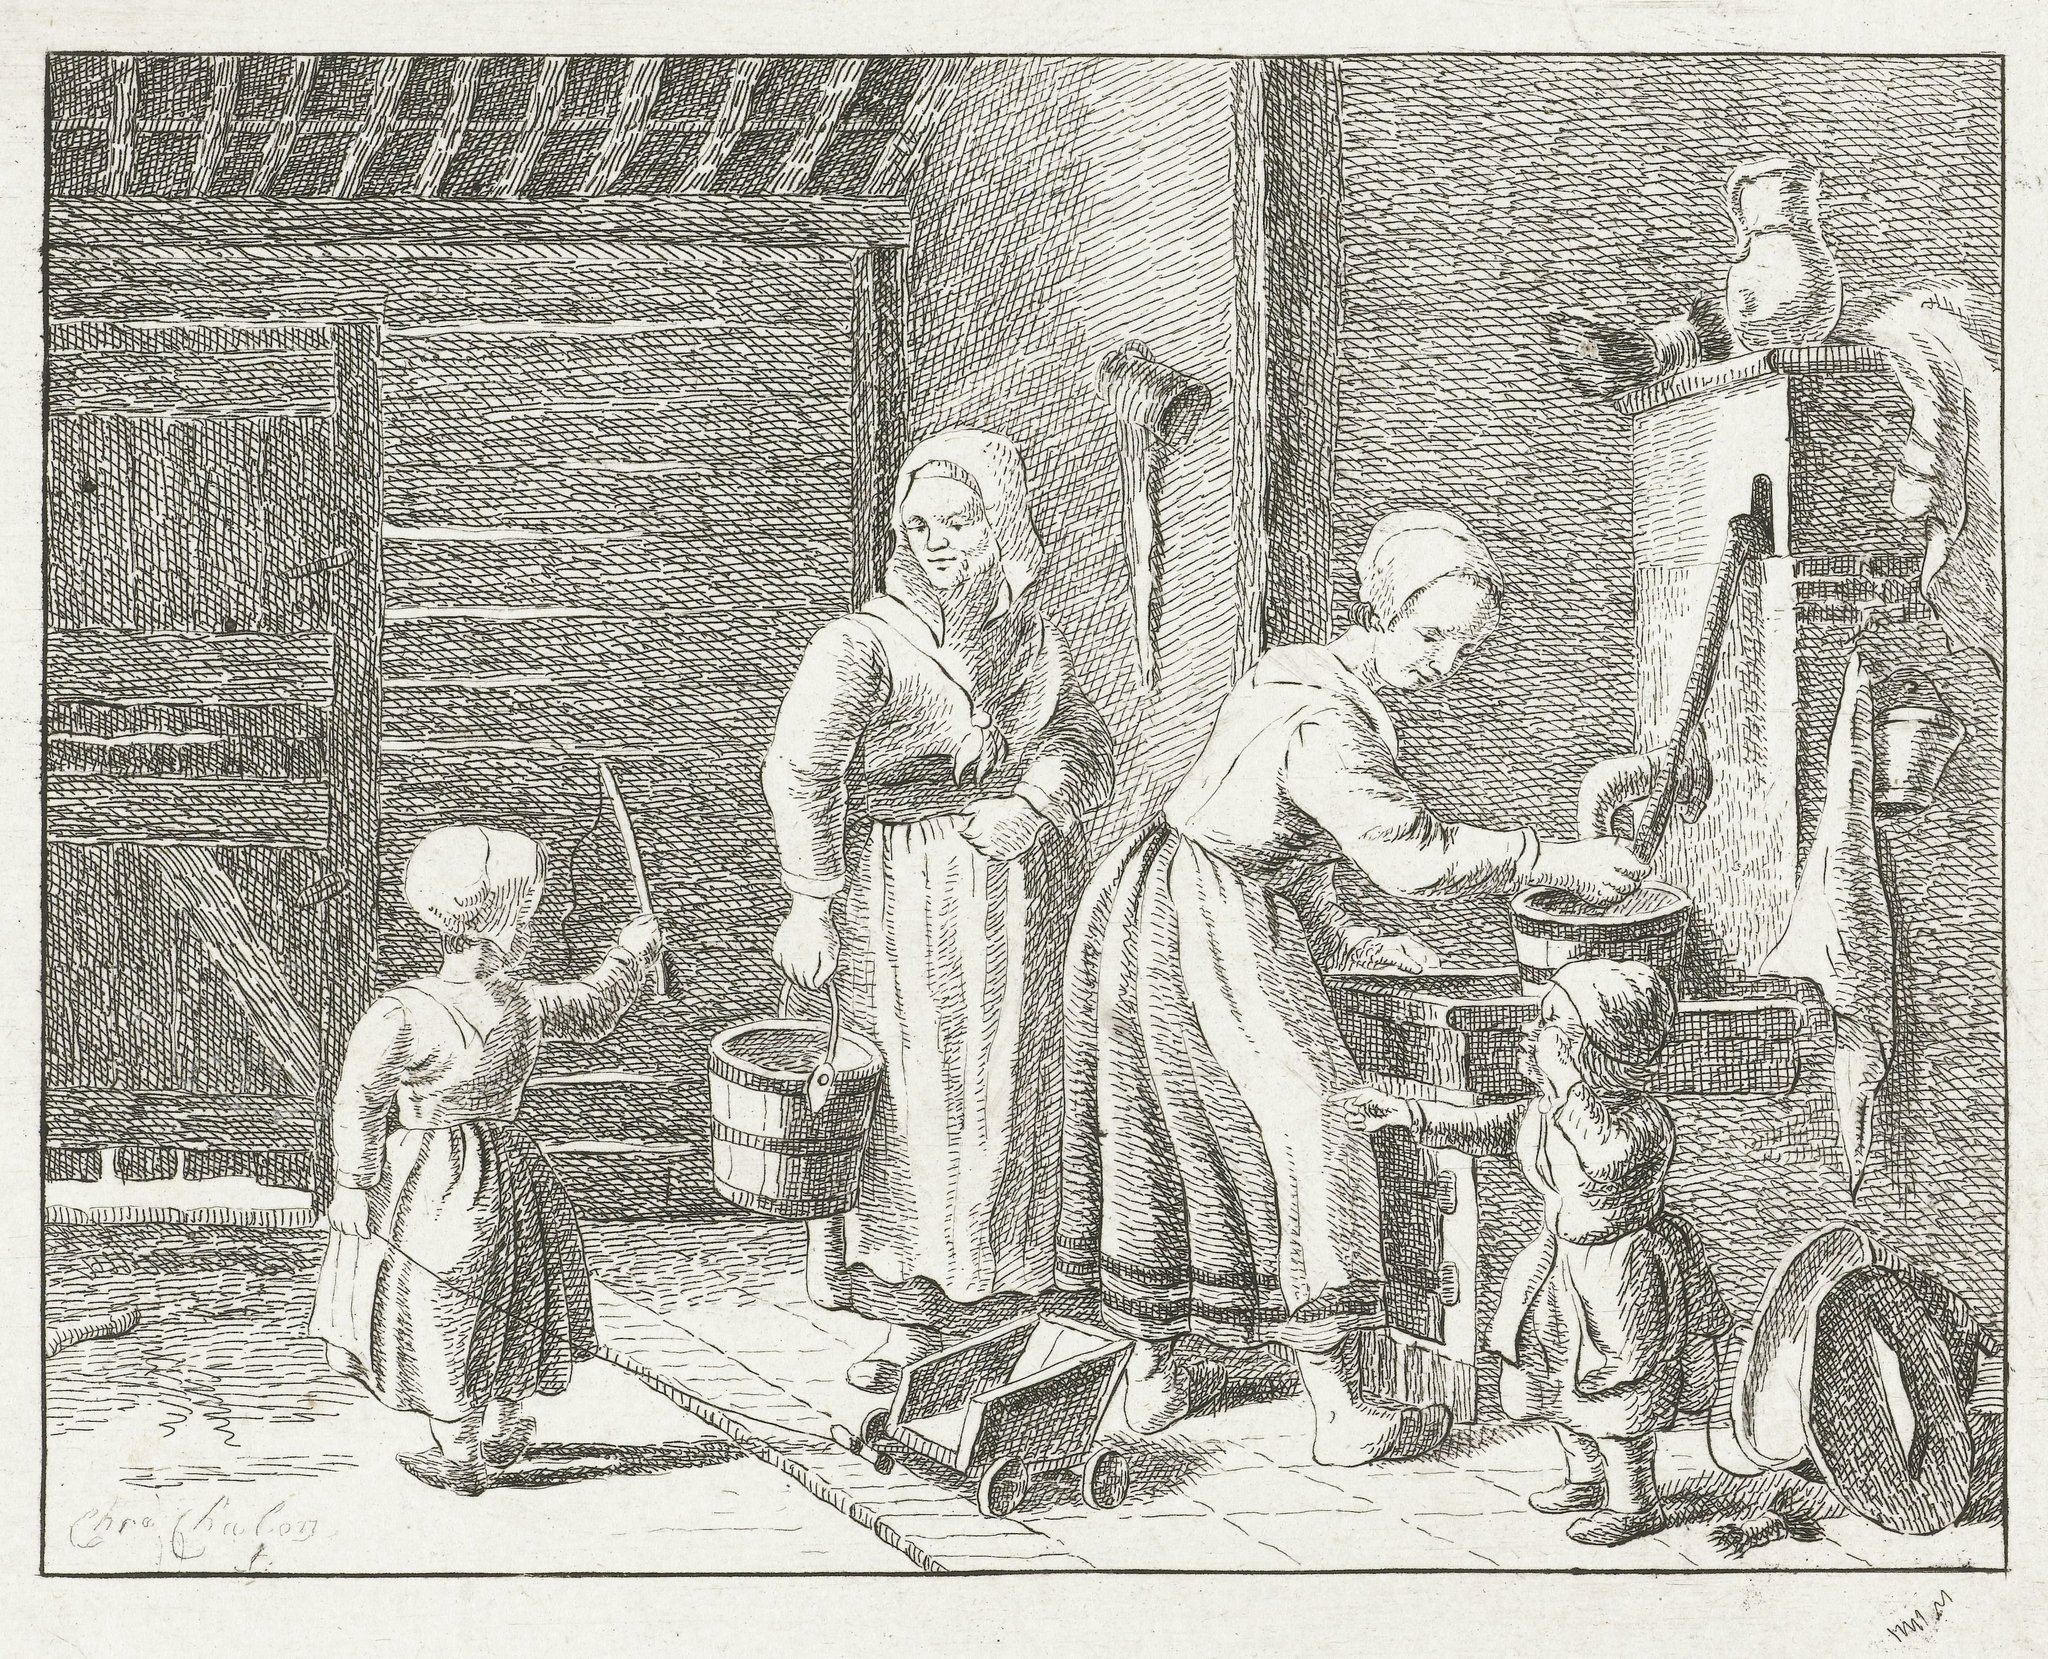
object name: print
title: Vrouwen en kinderen in interieur bij waterpomp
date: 1779-1796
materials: paper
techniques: etching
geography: leiden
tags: farmers - aa - female farmer, farmer's wife, weeping, (playing with) wheeled vehicles, pump, mother and daughter(s) (family group) (with number of daughters)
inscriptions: collector's mark: Lugt 2233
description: Twee vrouwen pompen water uit een pomp. Hun kinderen zijn aan het spelen. Het oudste meisje speelt met een rolwagen en een zweepje. De jongste huilt omdat haar speelgoed door de oudste is afgepakt.